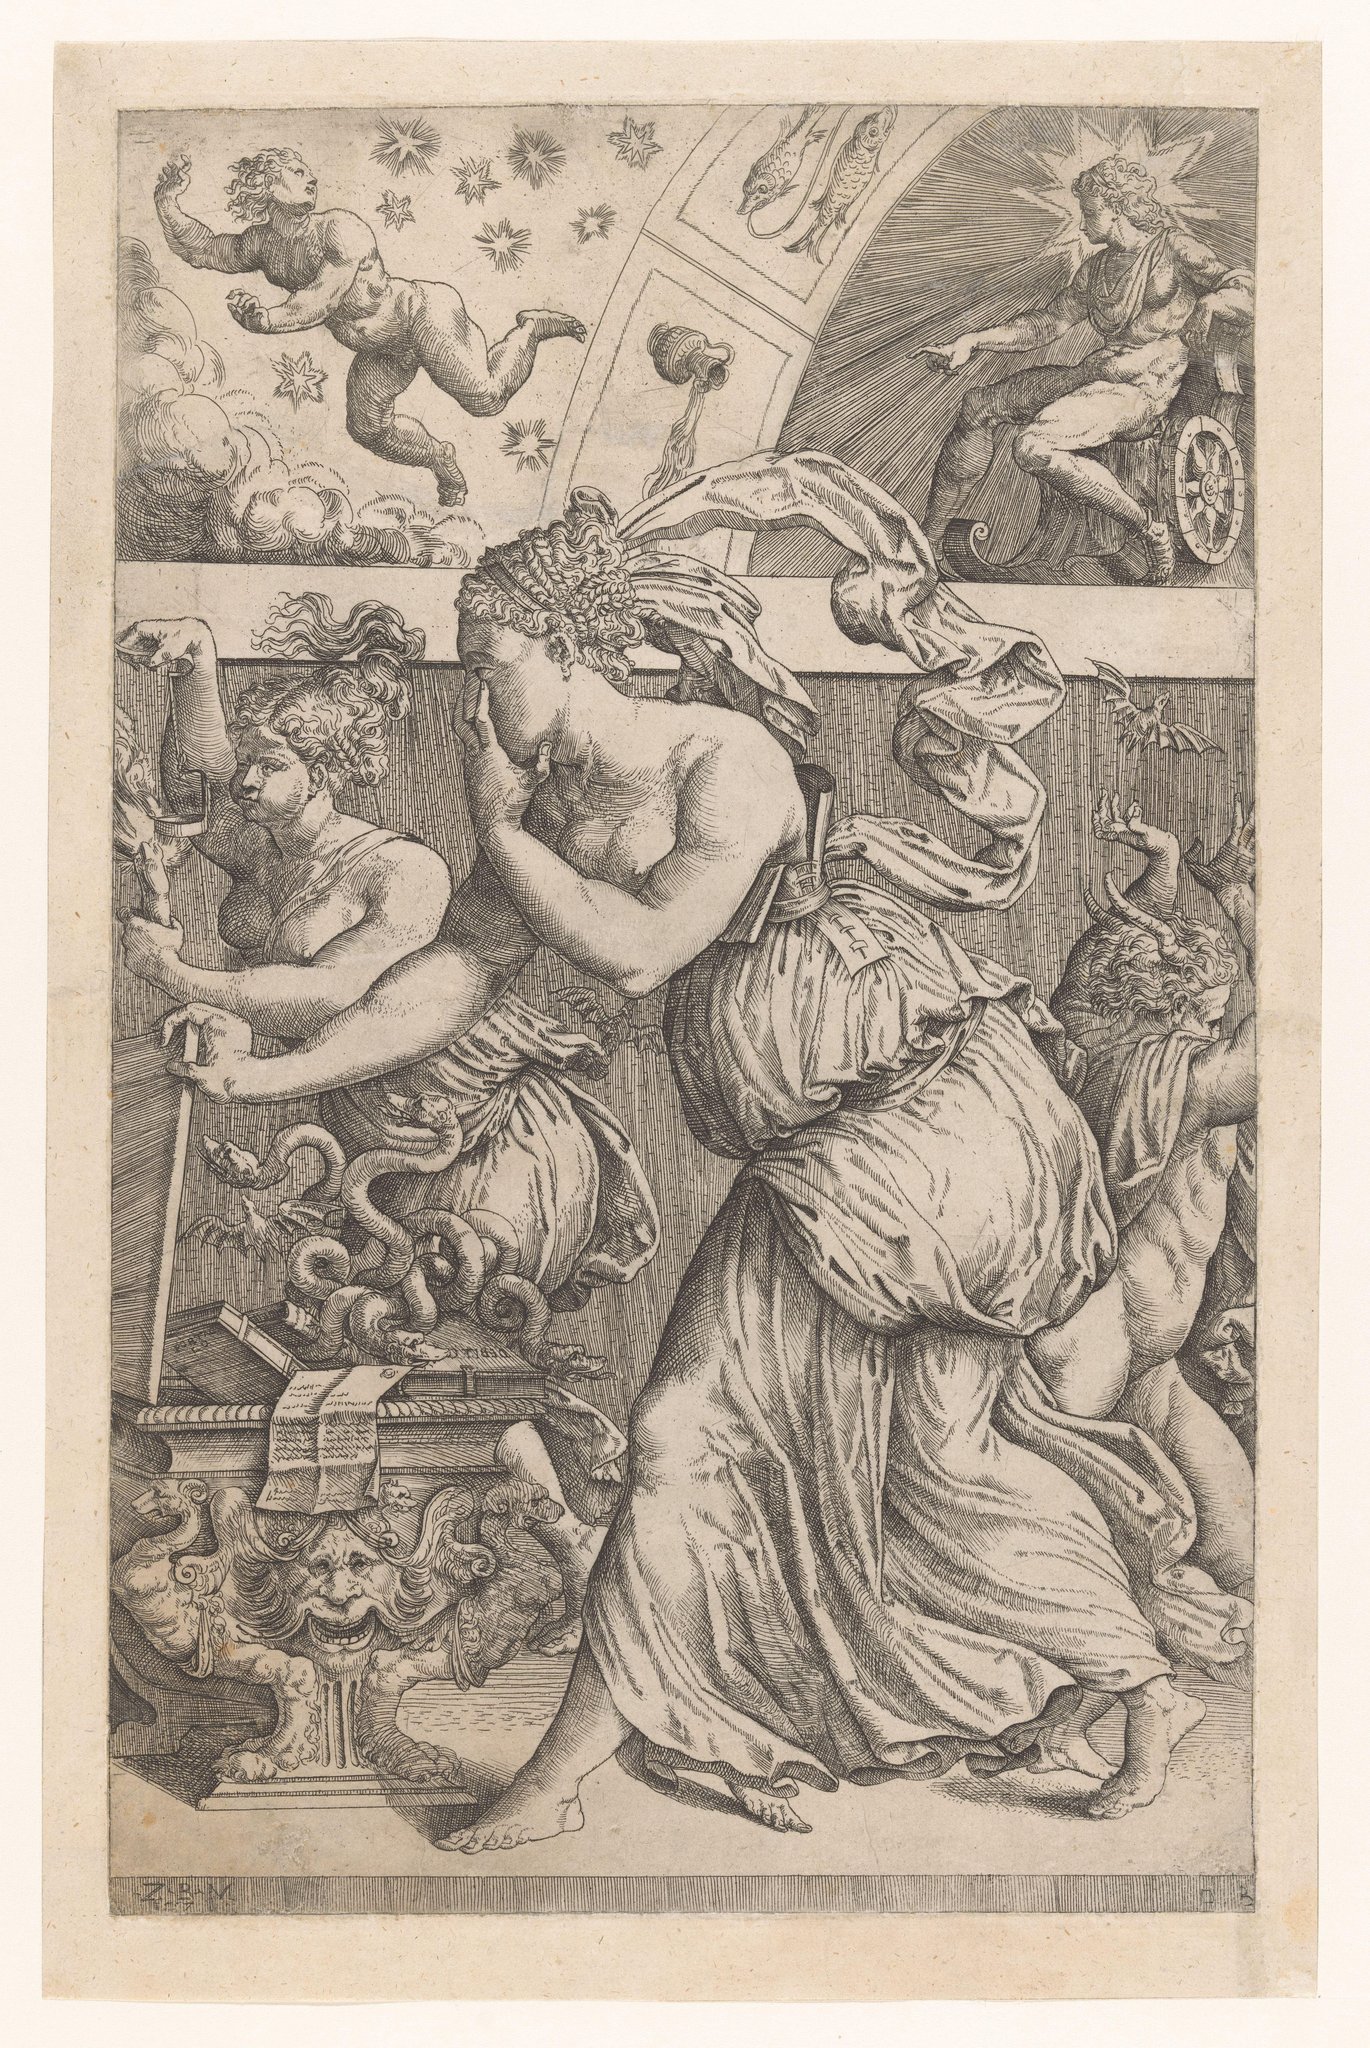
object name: print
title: Allegorie op de wetenschap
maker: monogrammist zbm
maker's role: print maker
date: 1557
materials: paper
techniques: etching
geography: italy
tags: snakes, knowledge; 'cognitione', 'cognitione delle cose' (ripa), chest, coffer, zodiacal signs of the winter season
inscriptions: collector's mark: Lugt 2233, collector's mark: Lugt 2228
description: Een vrouwelijke figuur houdt met haar vingers haar eigen ogen geopend. Met haar rechter hand opent zij een kist met boeken, slangen en een vleermuis. Achter de kist staat een tweede vrouw met een brandende fakkel: het licht van de waarheid. Rechts staat een duivel. Boven een deel van een wandschildering met tekens van de dierenriem en goden.